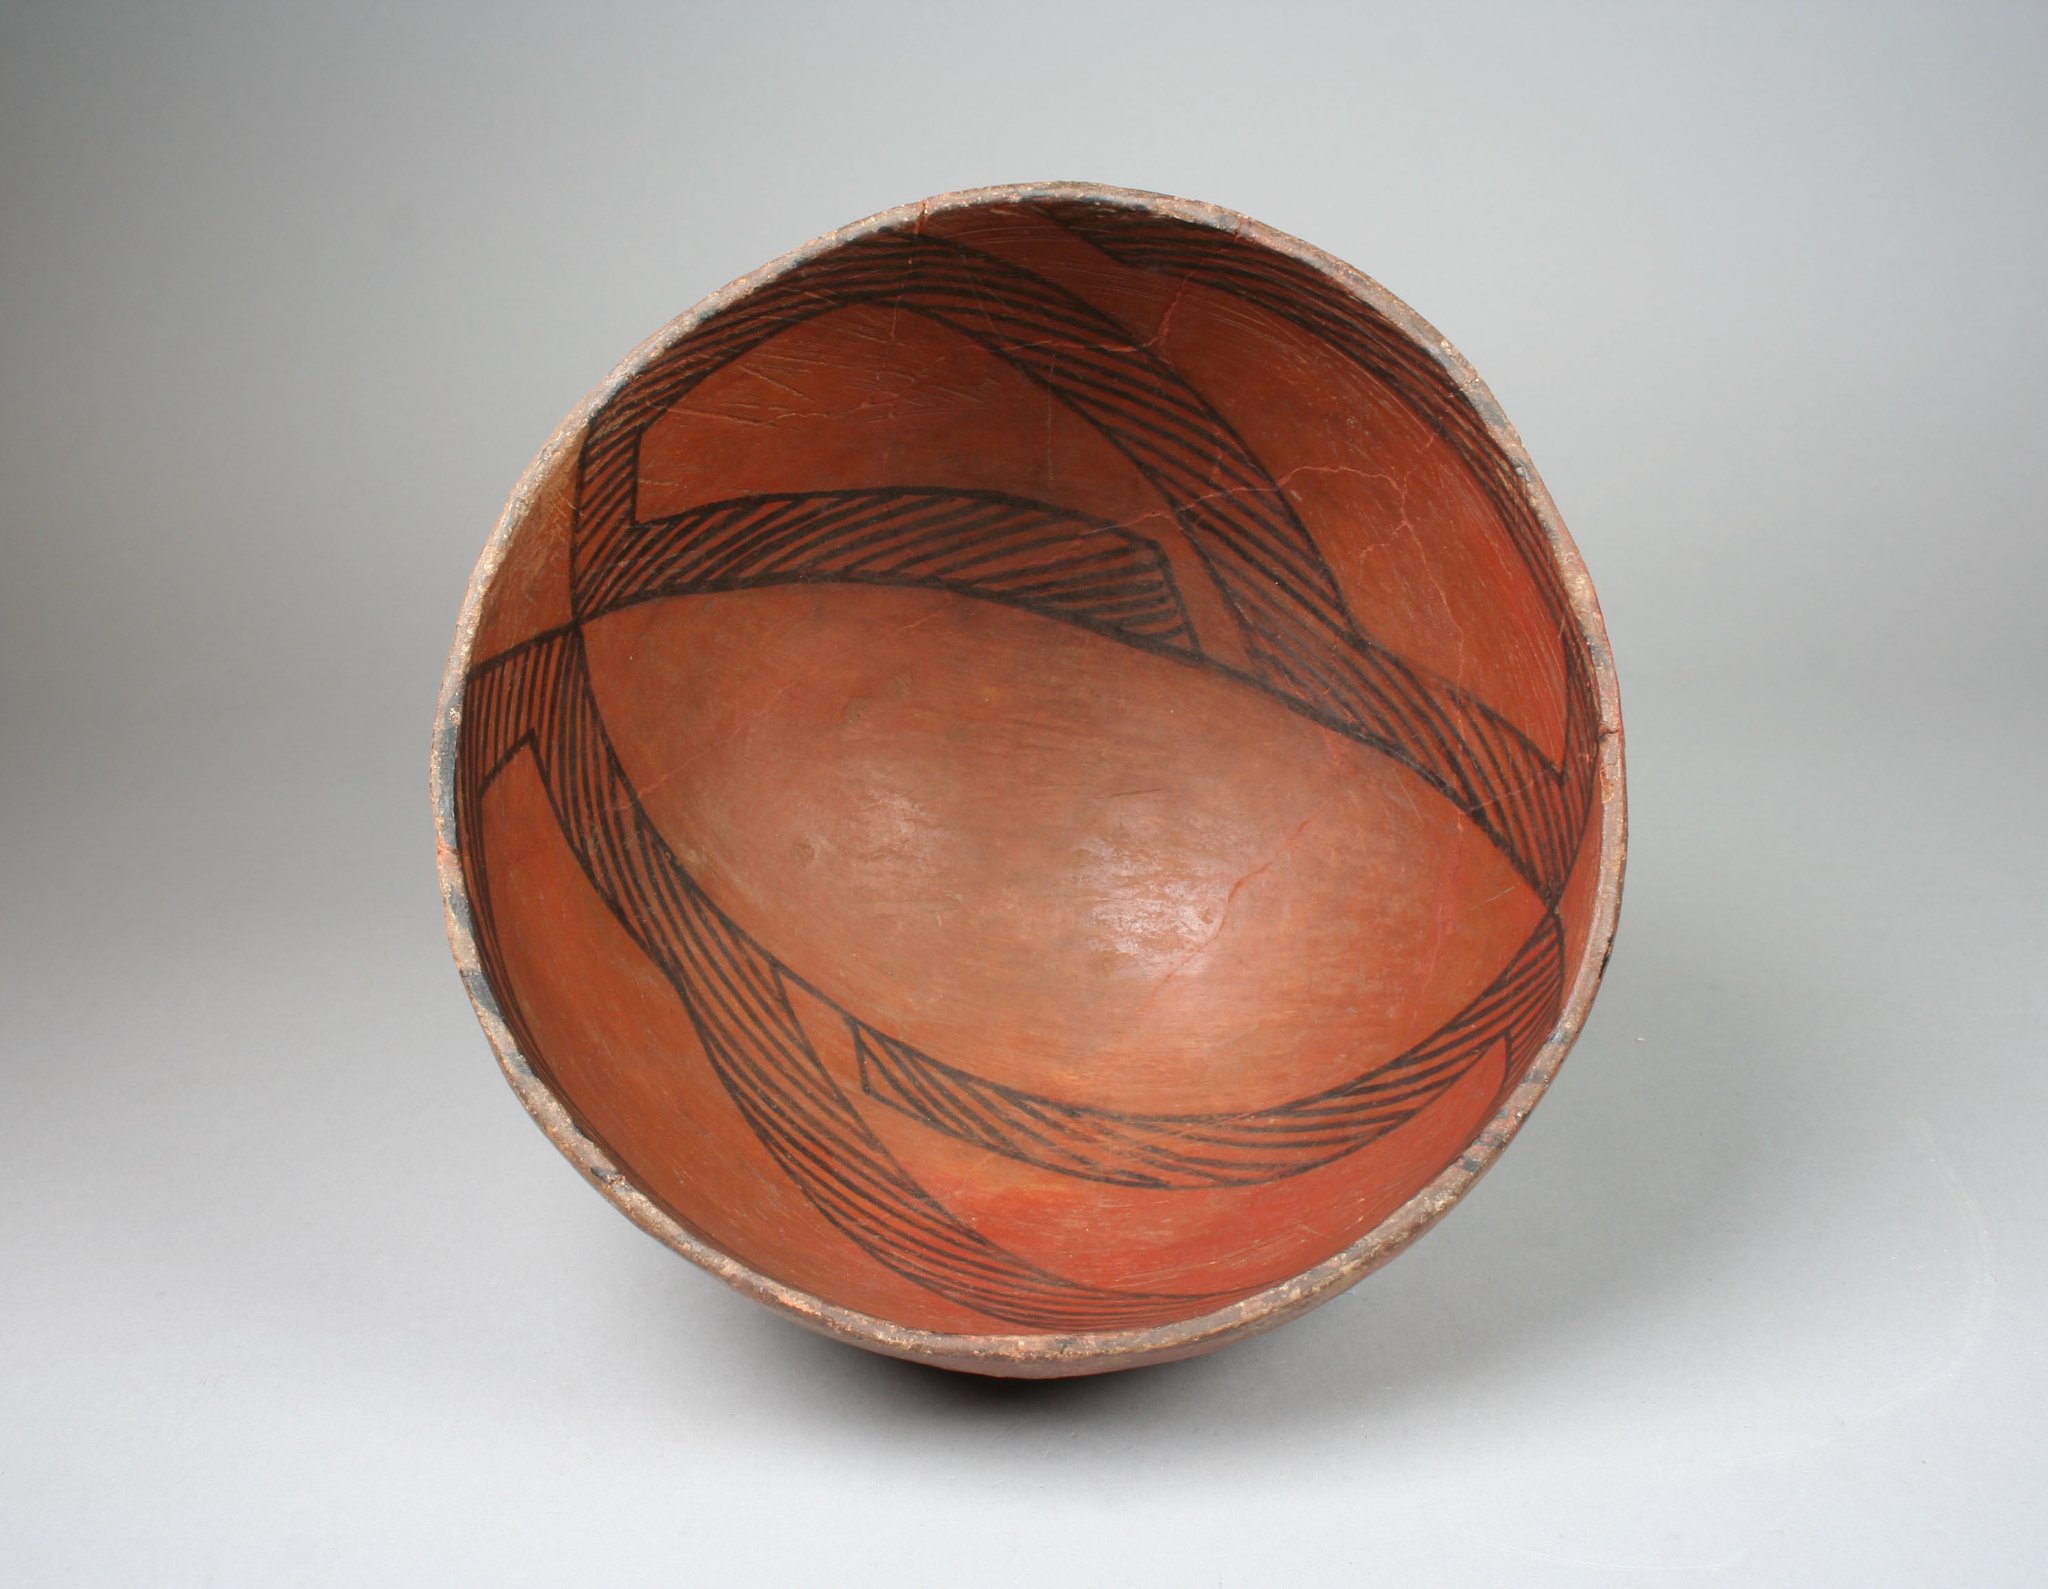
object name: bowl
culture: ancestral pueblo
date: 901-1100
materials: ceramic, pigment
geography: united states